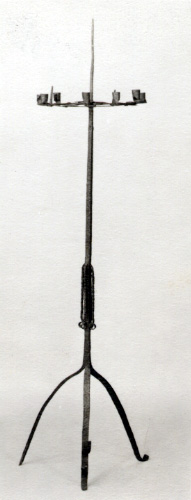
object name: candelabrum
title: Candelabra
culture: french or spanish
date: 1401-1500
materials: iron